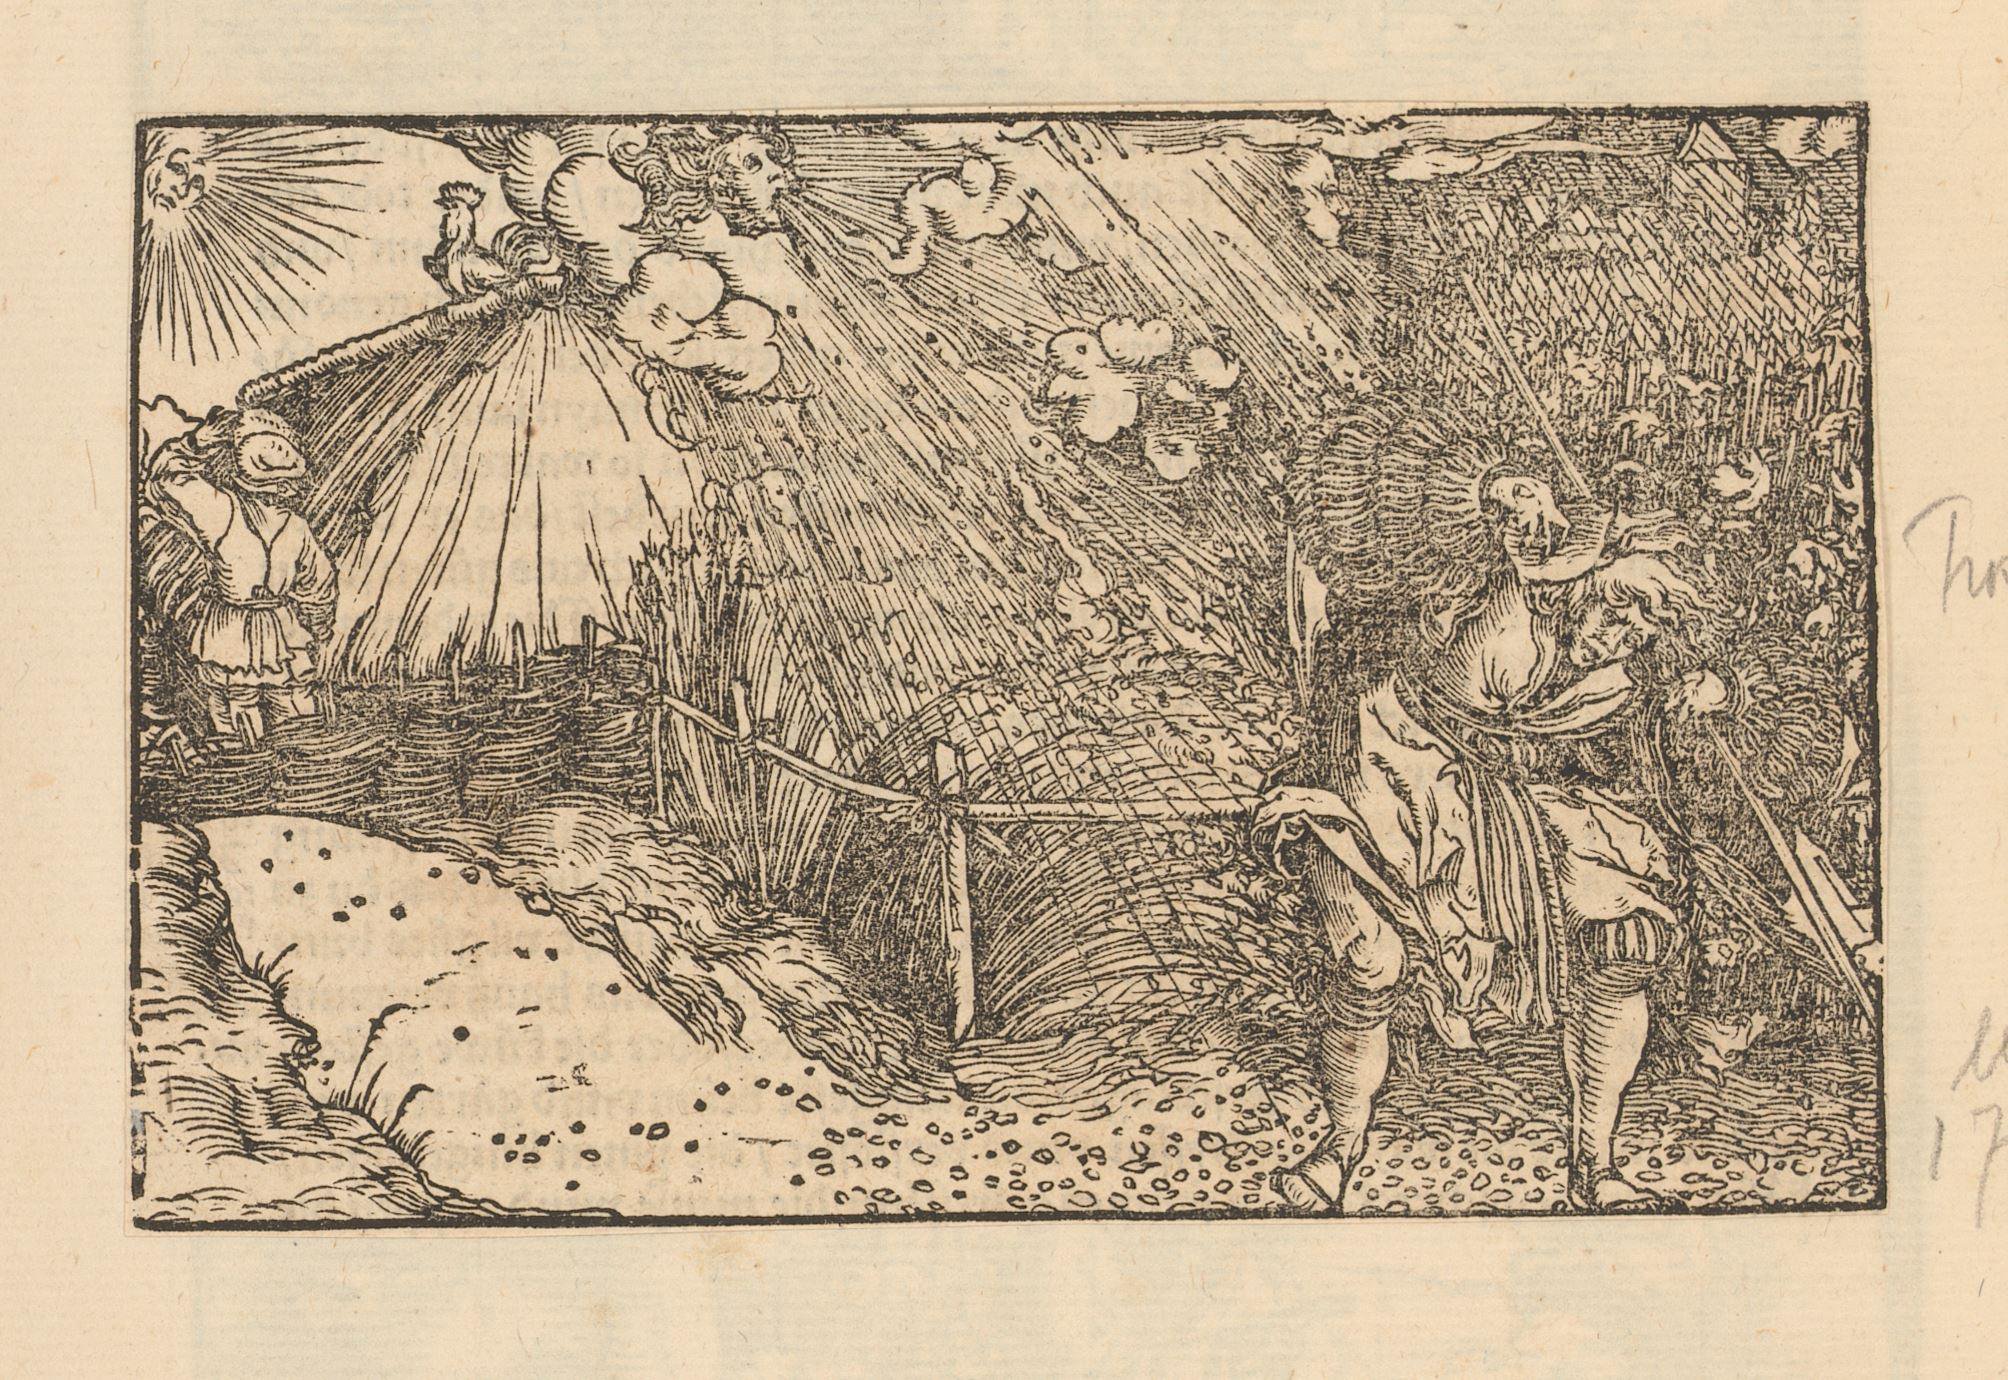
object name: album leaf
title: Boer op zijn land in een hagelstorm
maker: Anonymous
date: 1514-1532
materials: paper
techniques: letterpress printing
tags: hail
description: Deze prent is gebruikt in: Petrarca, Francesco. Von der Artzney bayder Glück, des guten und widerwertigen: unnd weß sich ain yeder inn Gelück und Unglück halten sol (...). Augsburg: Heinrich Steiner, 1532. Deze uitgave is ook bekend onder de titel 'Trostspiegel in Glück und Unglück'.